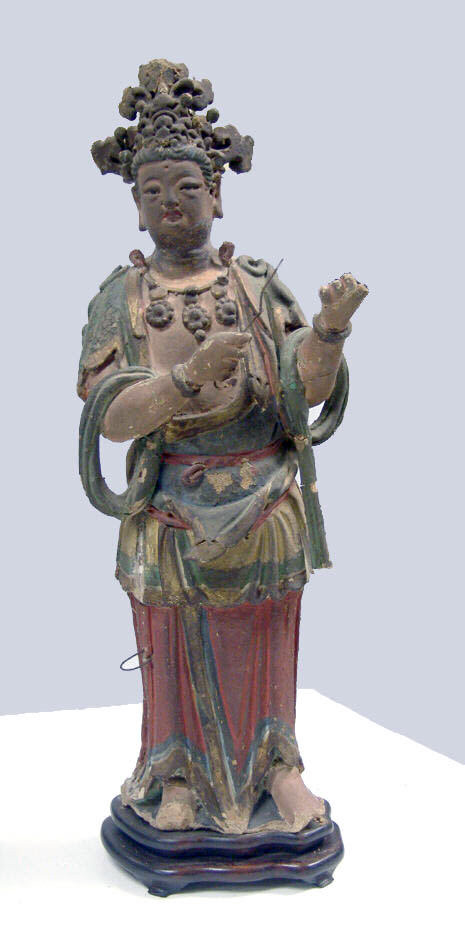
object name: statuette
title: A Bodhisattva, probably Guanyin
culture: chinese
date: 1368-1644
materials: mud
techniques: gilding, polychrome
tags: bodhisattvas